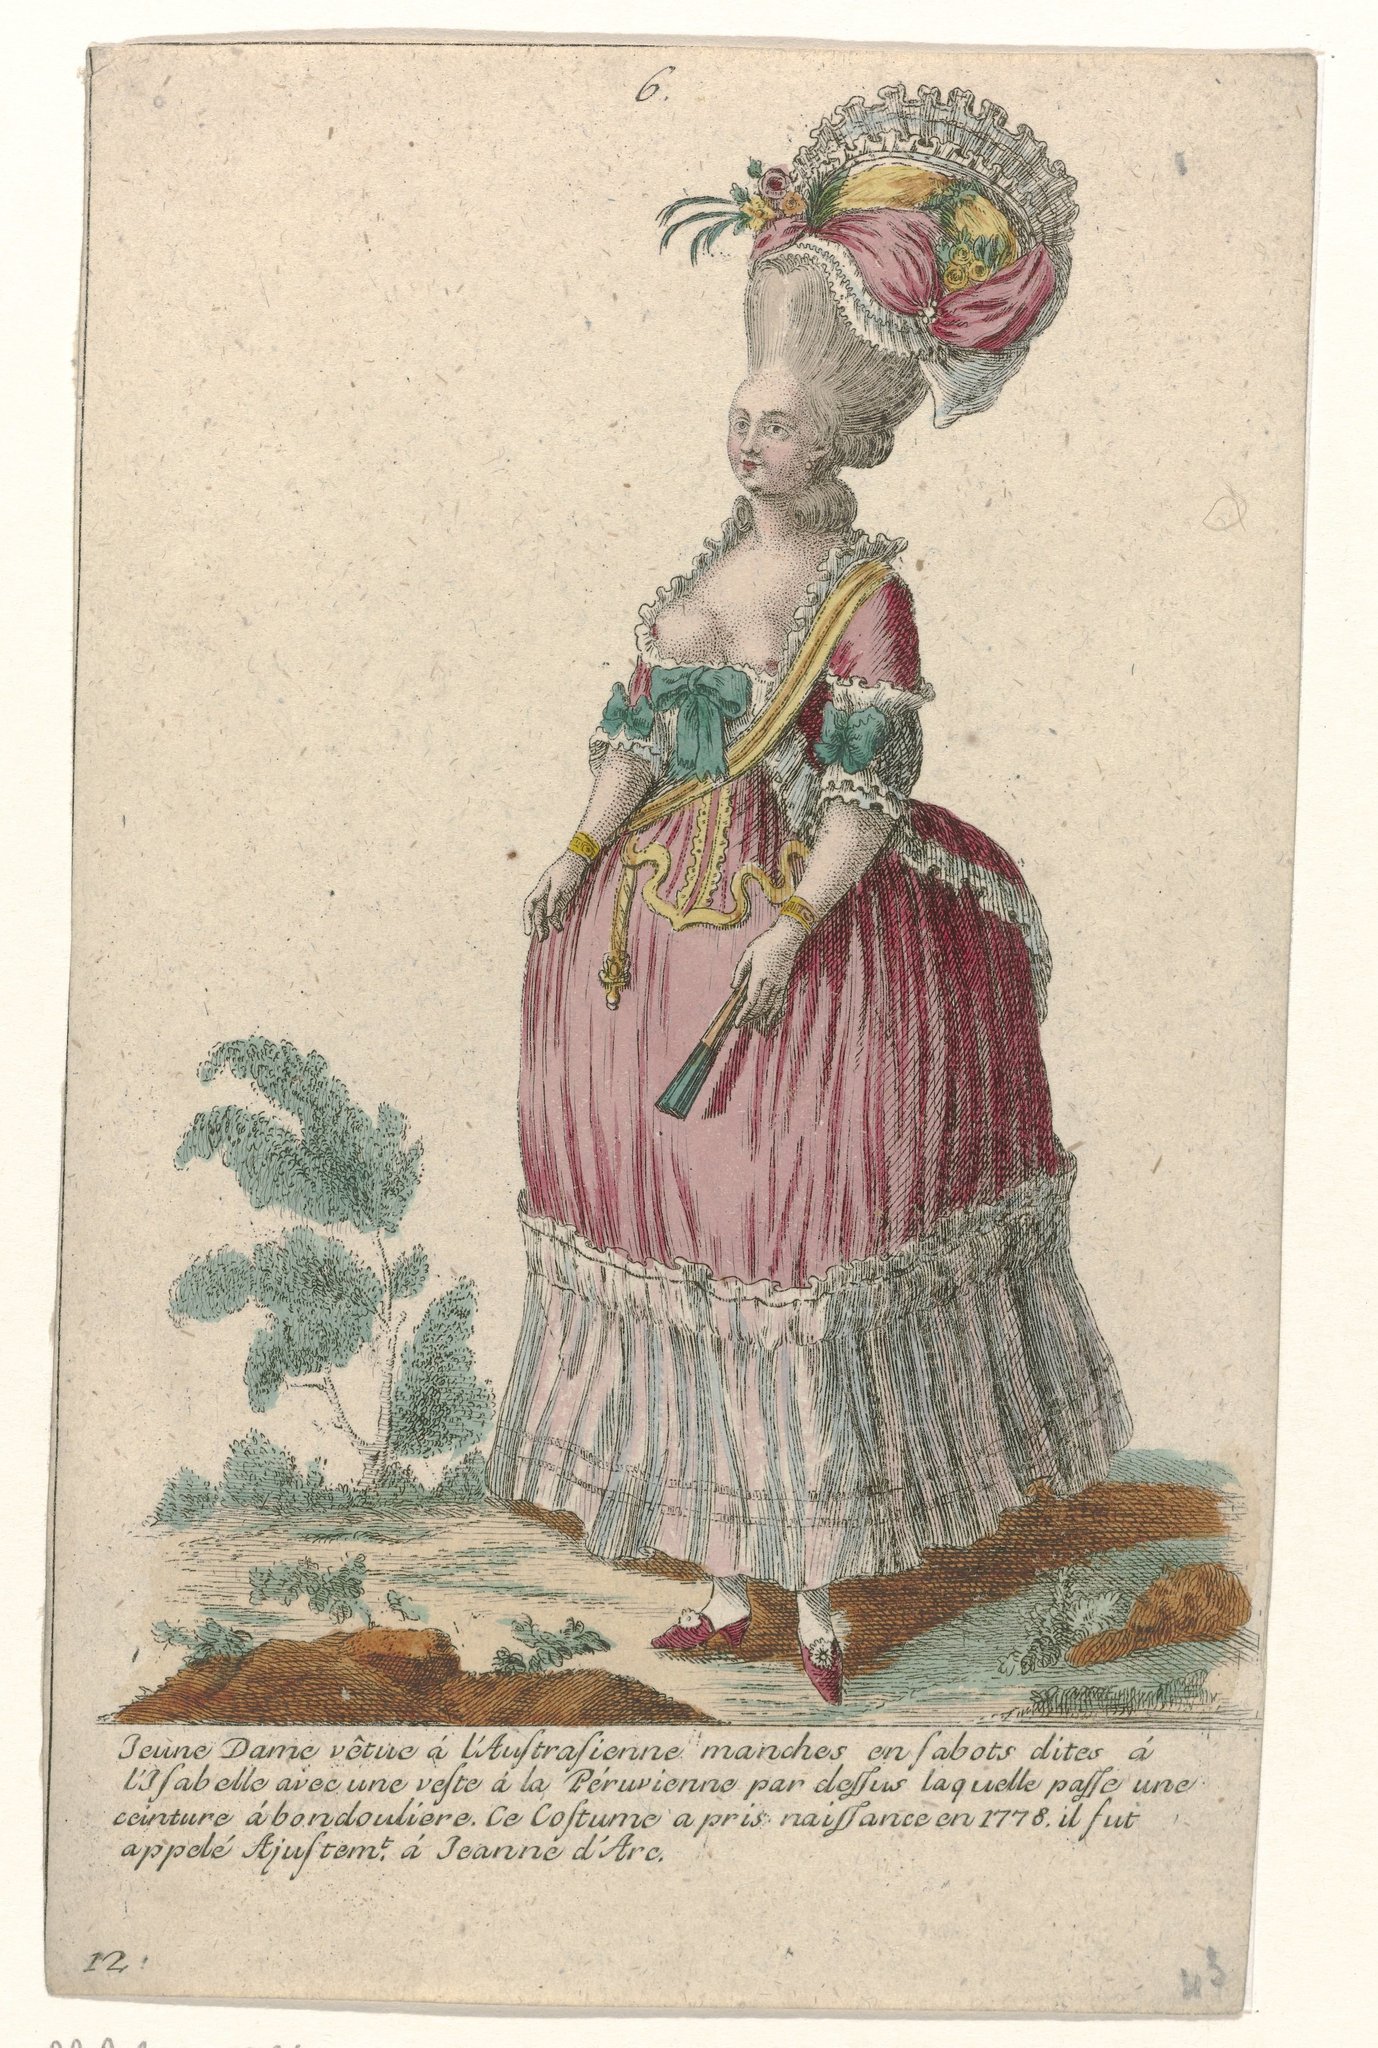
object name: fashion print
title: Gallerie des Modes et Costumes Français, 1785, nr. 6, nr.12, Kopie naar P 86 : Jeune Dame vêtue à l'Austrasienn (...).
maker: pierre gleich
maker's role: print maker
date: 1785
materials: paper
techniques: engraving, hand coloring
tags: clothing for the upper part of the body (+ women's clothes), styles of hairdress - aa - ~ women, head-gear: cap (+ women's clothes), fashion plates, skirt (+ women's clothes), fan (+ women's clothes)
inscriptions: caption: ‘Jeune Dame vêtue à l'Austrasienne manches en sabots dites á l'Isabelle avec une veste a la Péruvienne par dessus la quelle passe une ceinture á bondouliere. Ce costume a pris naissance en 1778. il sut appelé Ajustem.t á Jeanne d'Arc.’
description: Staande jonge vrouw met een ontblote boezem, gekleed 'à l'Austrasienne' met manches en sabot genaamd à l'Isabelle en een vest à la Péruvienne, waarover een schouderband. Zij draagt een rok afgezet met aangerimpelde strook en kousen. Accessoires: muts met lint, armbanden, chatelaine, waaier, muiltjes met rozetten(?). Volgens het onderschrift ontstond dit kostuum in 1778 en werd genoemd: ajustement à Jeanne d'Arc. Kopie naar P 86 uit serie P. 15e Cahier des Costumes Français, 9e Suite d'Habillemens à la mode en 1778, Gallerie des Modes et Costumes Français.